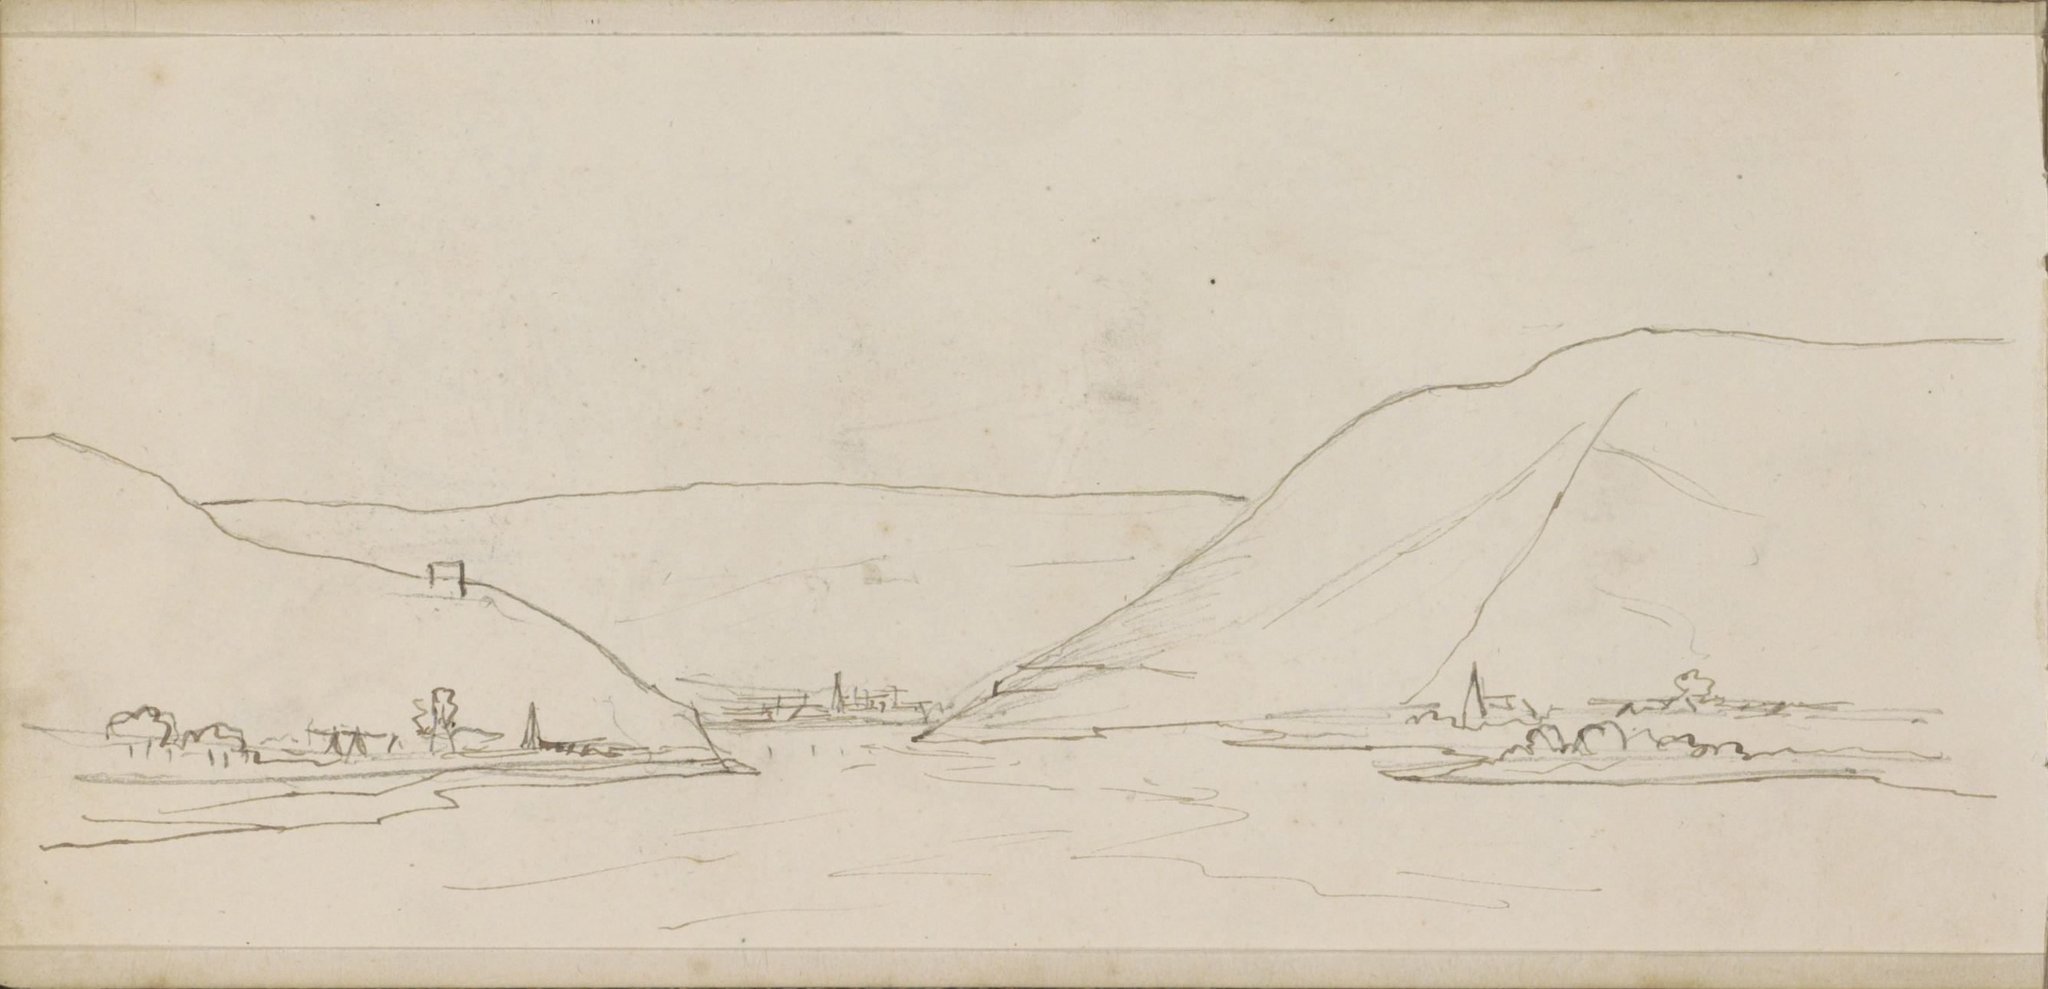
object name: sketchbook leaf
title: Landschap met bergen aan een meer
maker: johannes tavenraat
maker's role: draughtsman, painter, print maker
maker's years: 1809-1881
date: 1840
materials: ink, paper, pencil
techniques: pen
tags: landscapes with waters, waterscapes, seascapes (in the temperate zone), mountains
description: Blad 3 verso uit een schetsboek met 63 bladen.